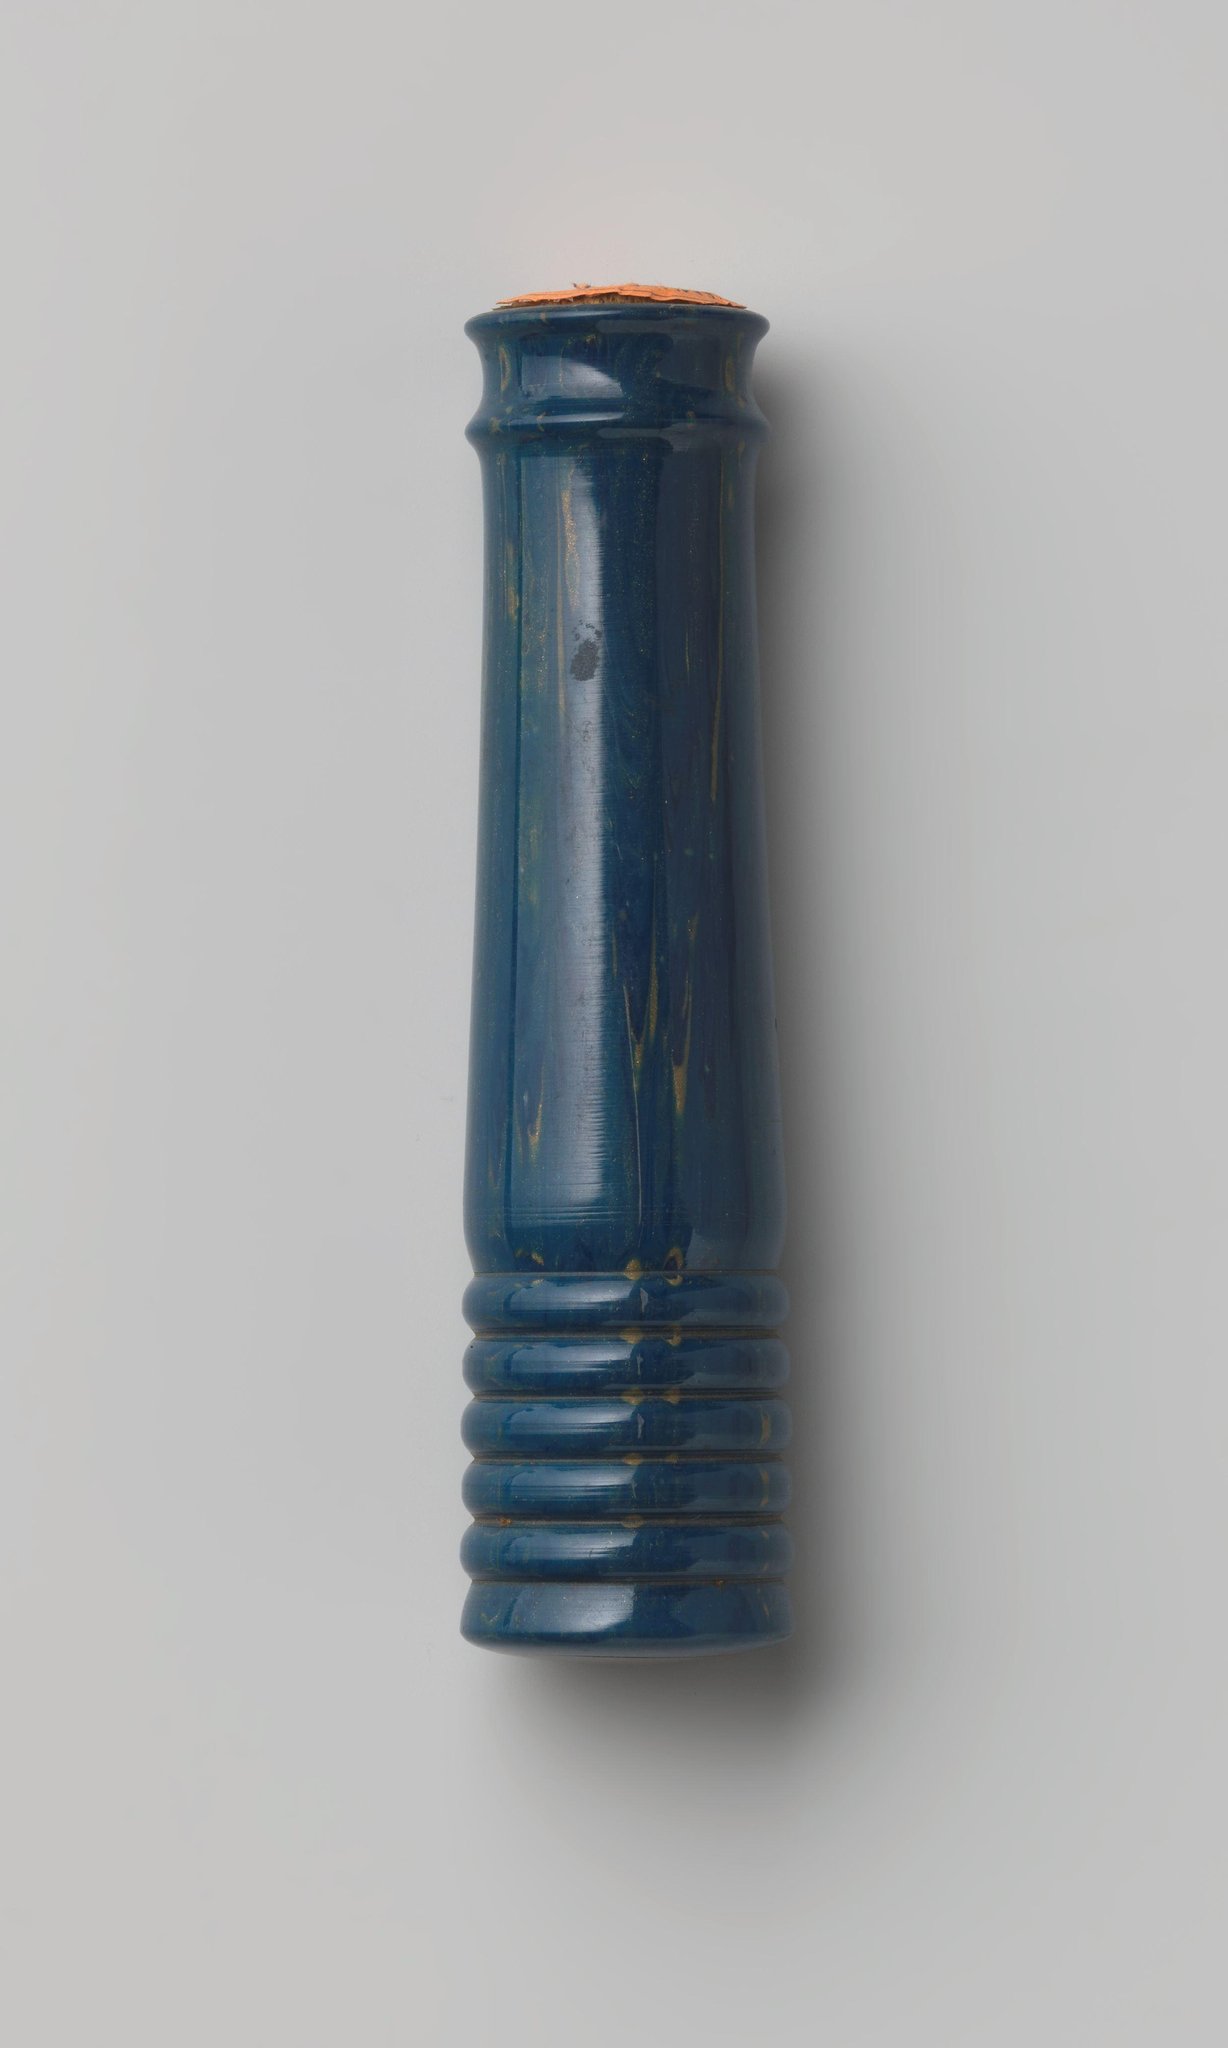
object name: parapluknop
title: Konische parasolknop of parapluknop van blauwgeverfd hout met gouden nerven of blauwe kunststof; de knop is ingelegd met rode steen of kunststof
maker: gustav schnitzler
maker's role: paraplufabrikant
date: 1920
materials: plastic, wood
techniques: inlay, polish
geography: nijmegen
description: Konische parasolknop of parapluknop van blauwgeverfd hout met gouden nerven of blauwe kunststof. De knop is ingelegd met rode steen of kunststof.